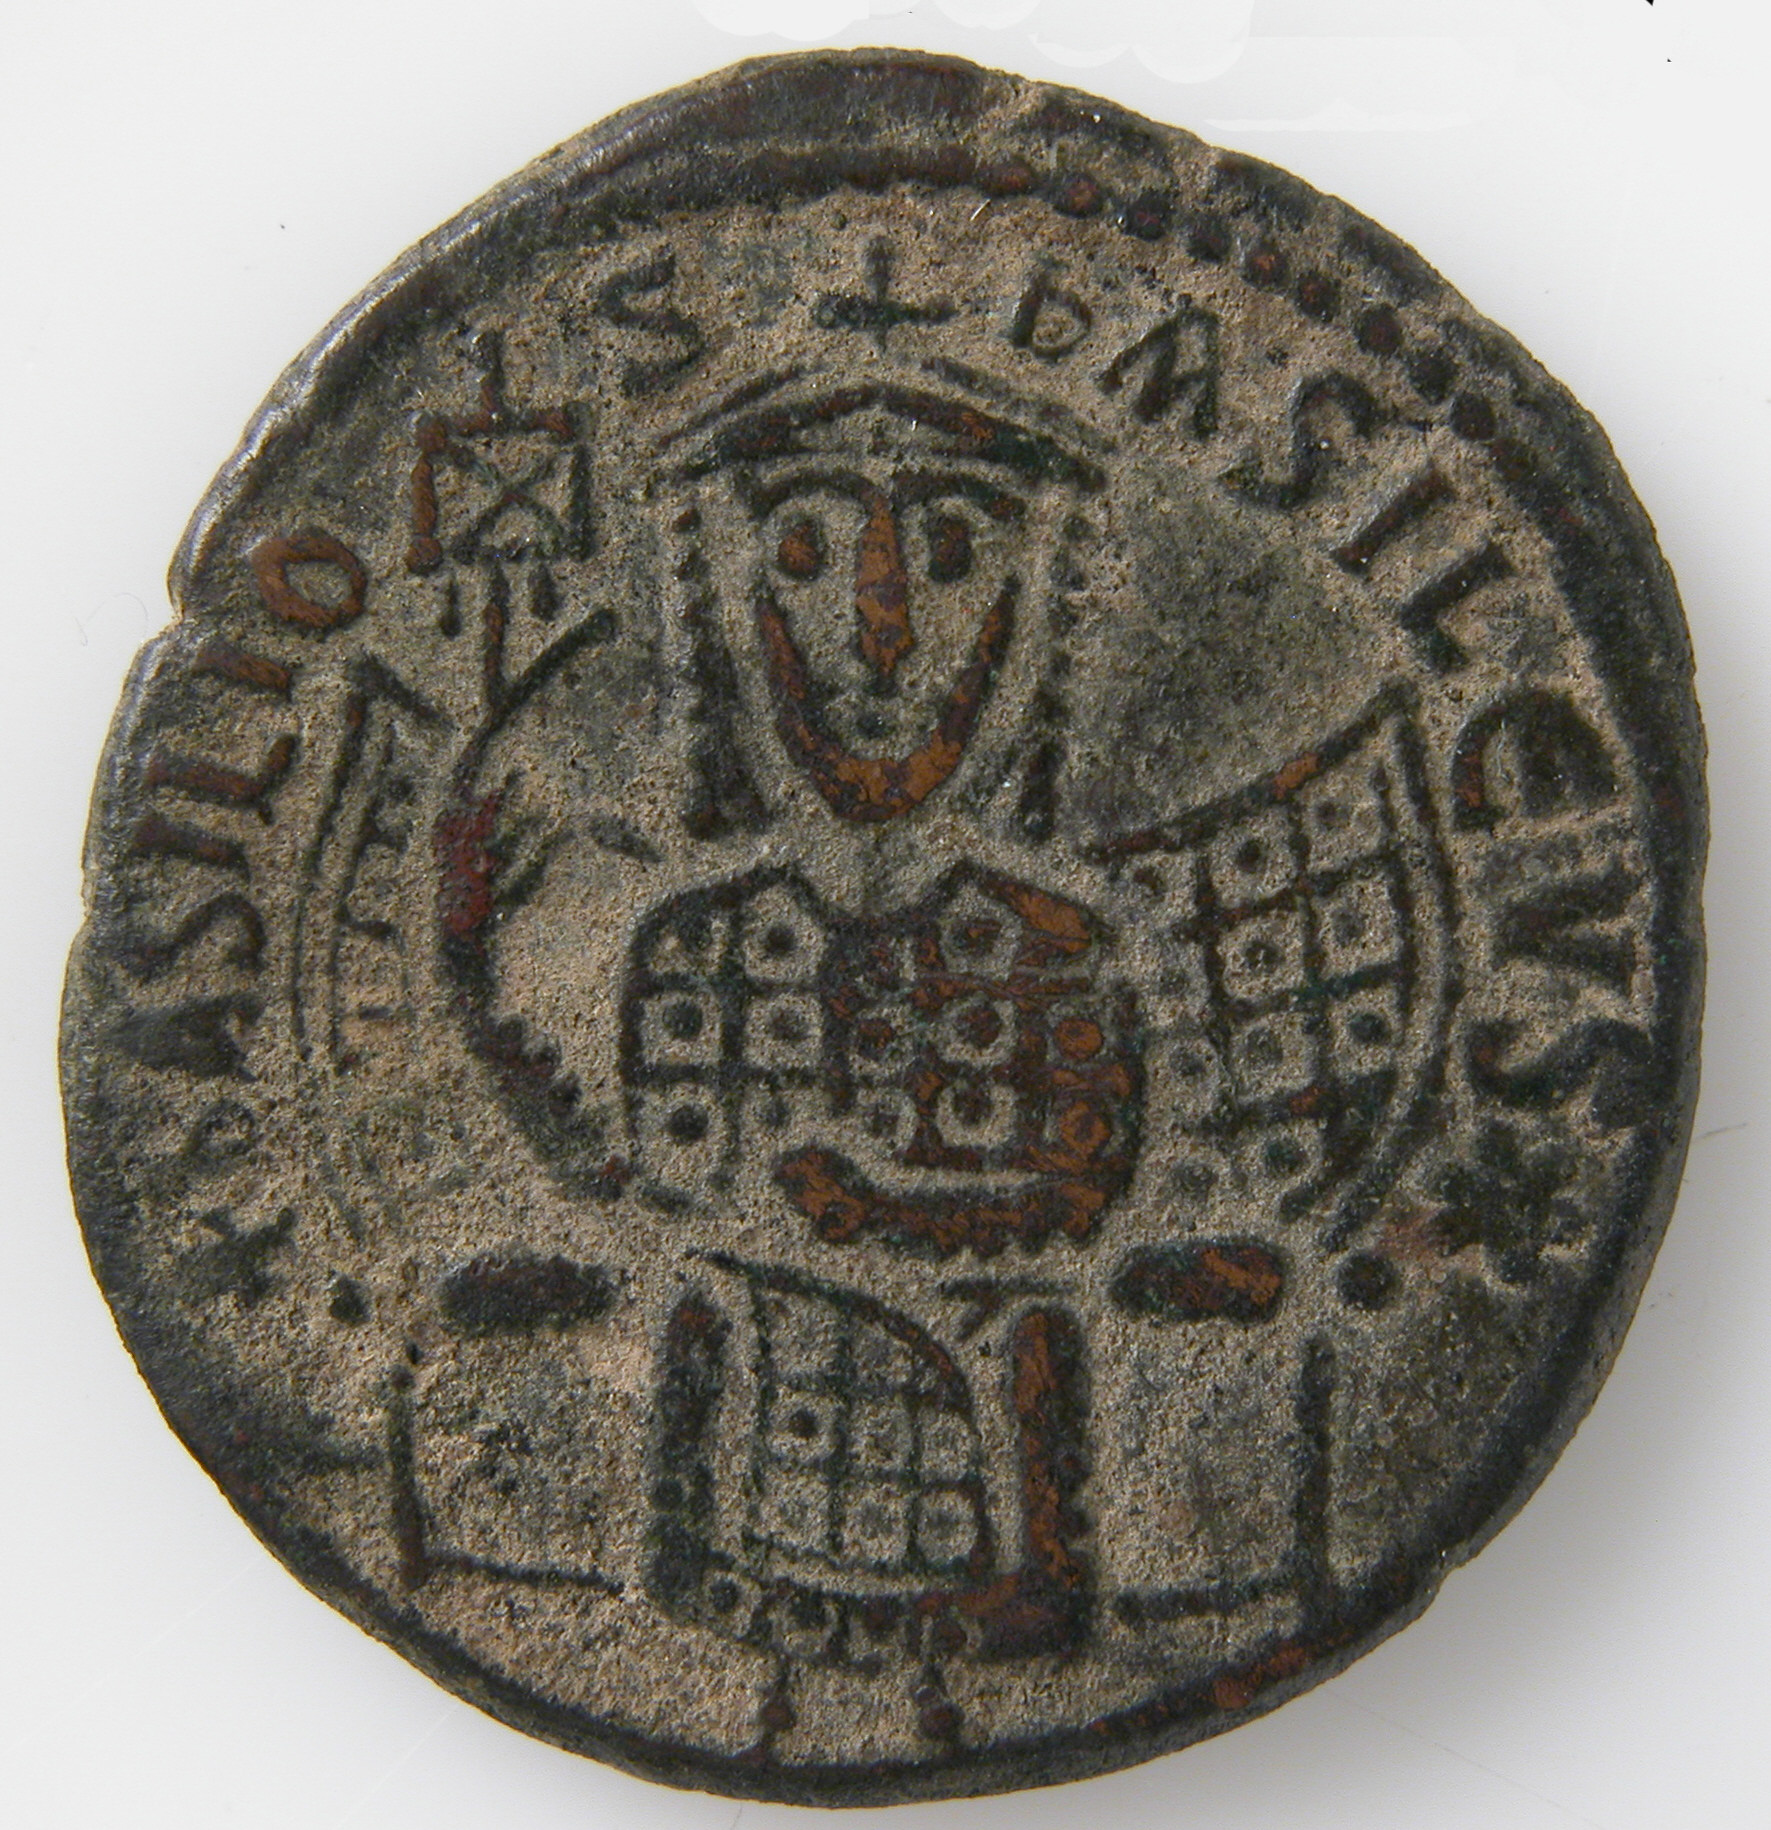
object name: coin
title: Coin of Basil I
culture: byzantine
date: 801-900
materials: copper alloy